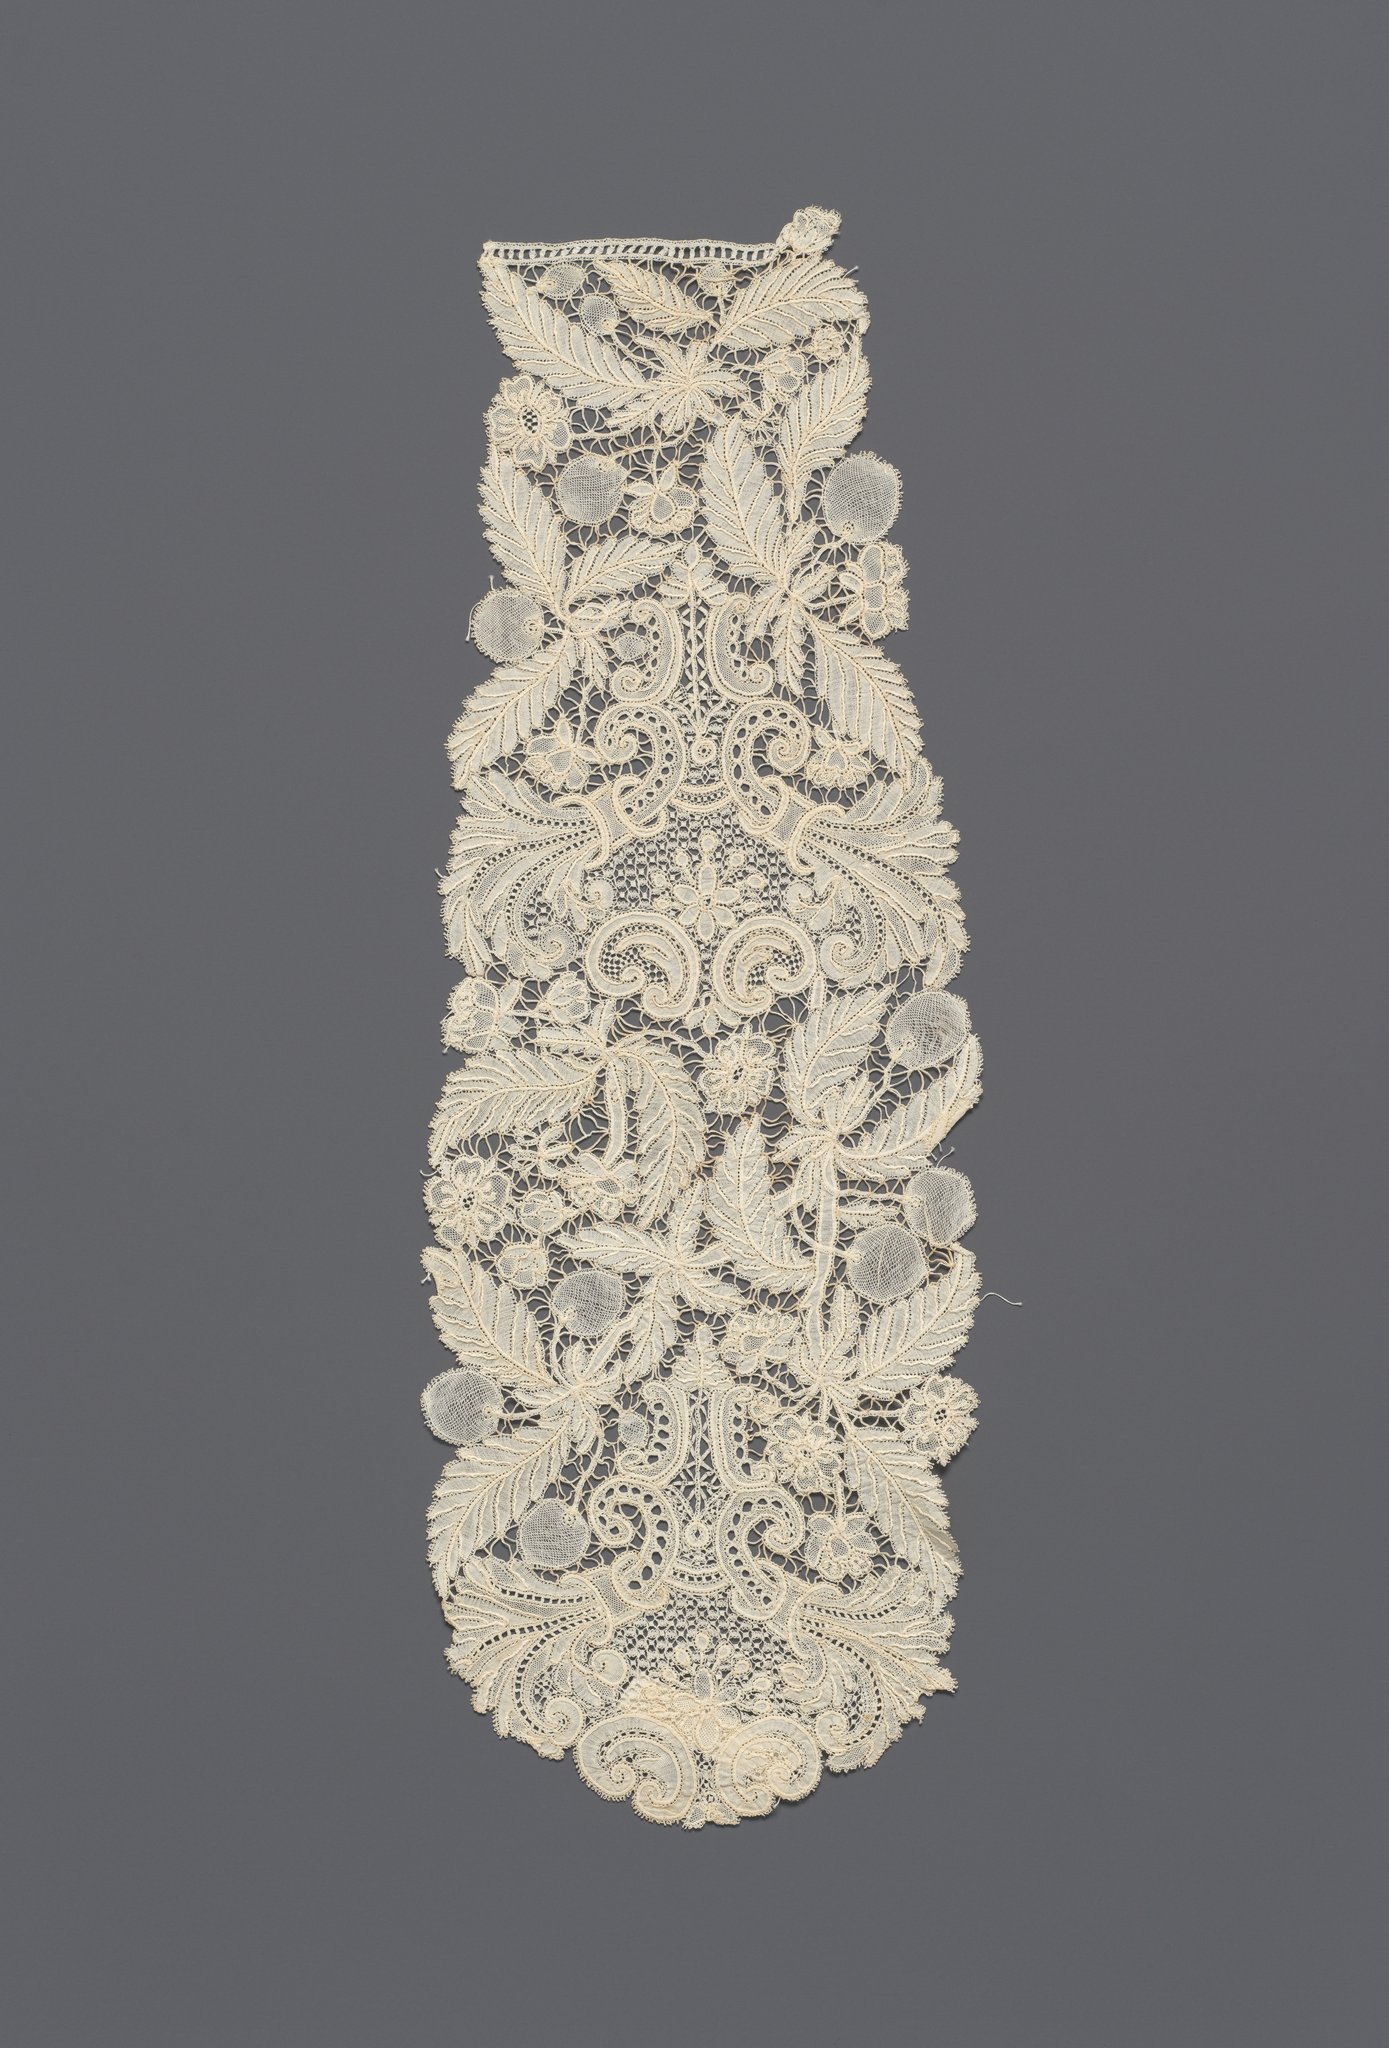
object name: lappet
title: Pair of lappets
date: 1801-1900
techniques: lace